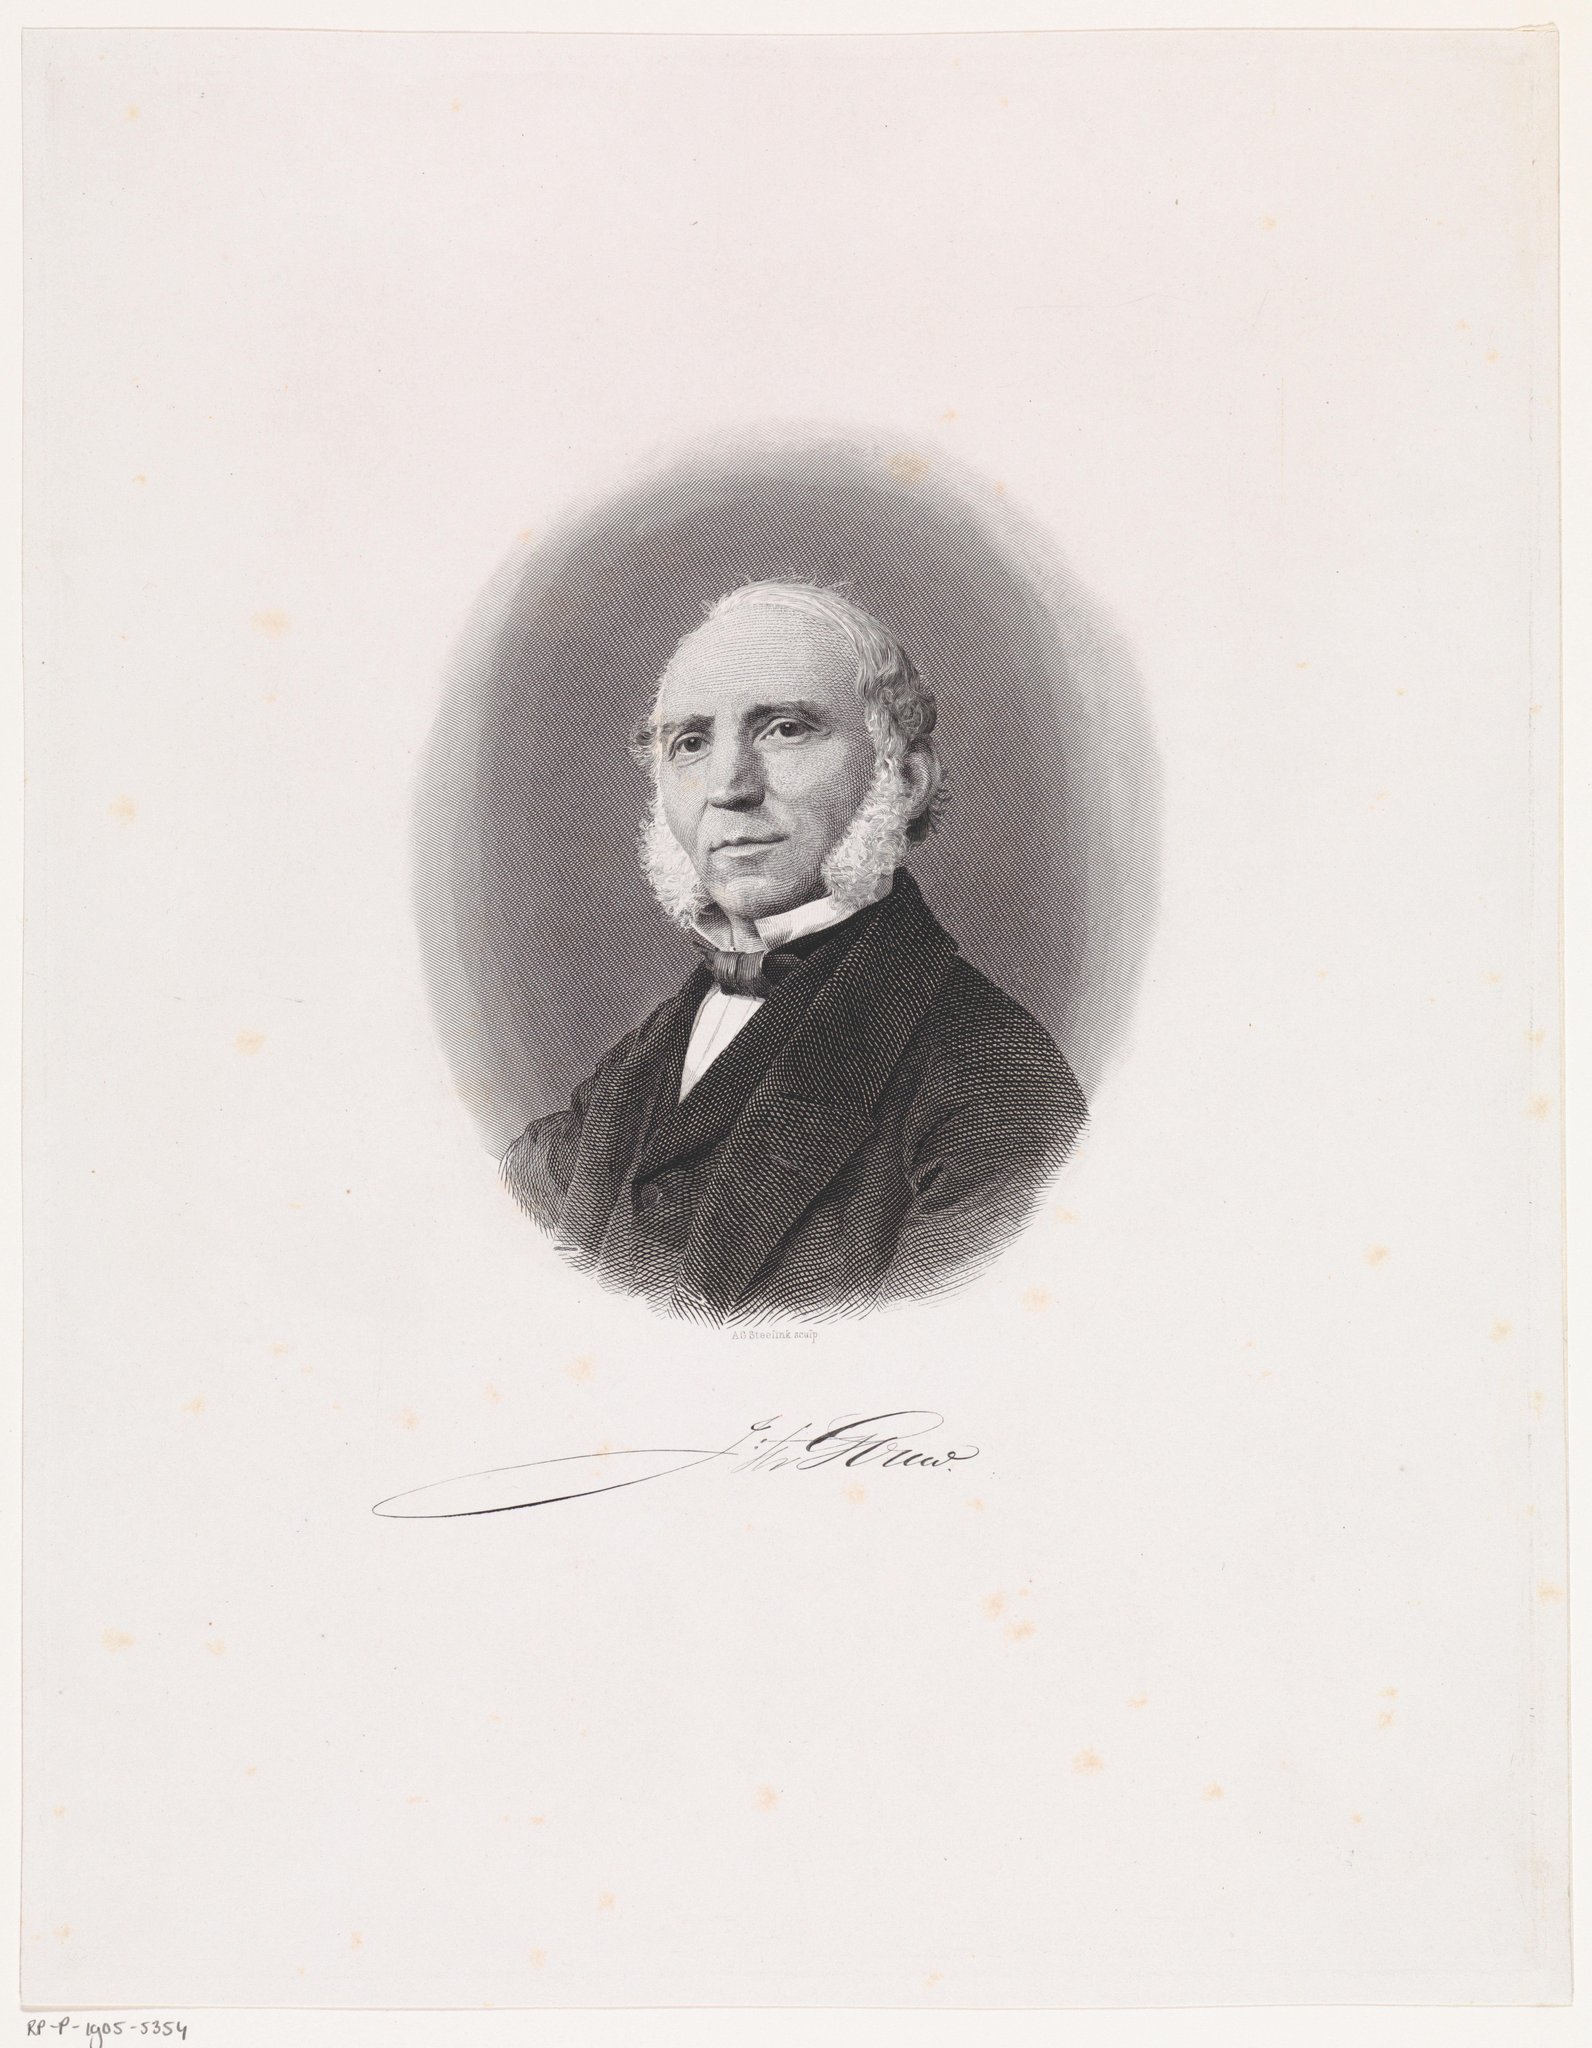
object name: print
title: Portret van Jan ter Gouw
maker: abram george steelink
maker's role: print maker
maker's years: 1844-1920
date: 1857-1905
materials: paper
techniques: engraving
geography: amsterdam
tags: jan ter gouw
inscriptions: collector's mark: Lugt 2228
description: Portret van Jan ter Gouw, geschiedschrijver te Amsterdam.